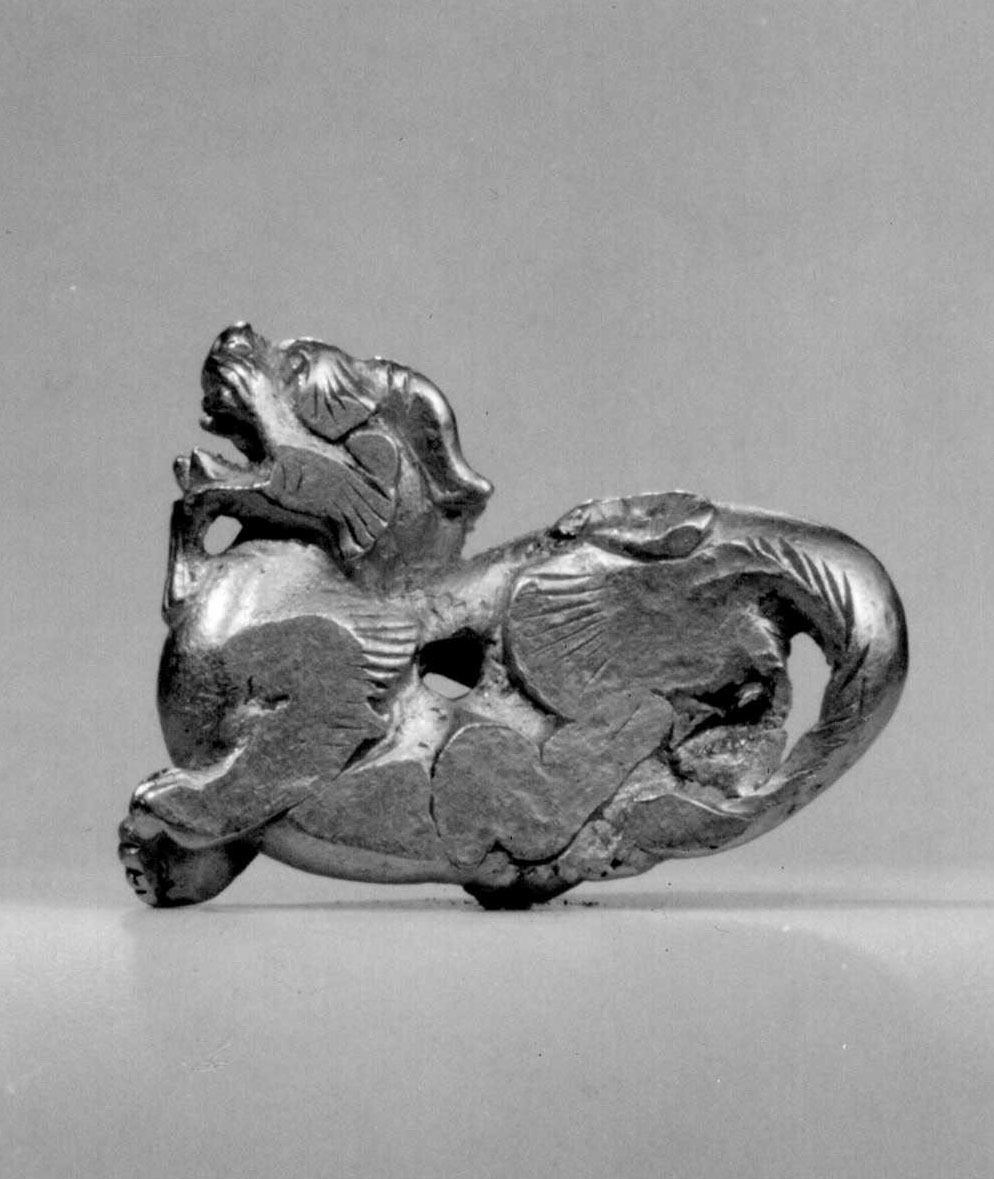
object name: ornament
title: Chimera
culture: chinese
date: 100 BCE-100 CE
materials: gold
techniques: casting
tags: mythical creatures